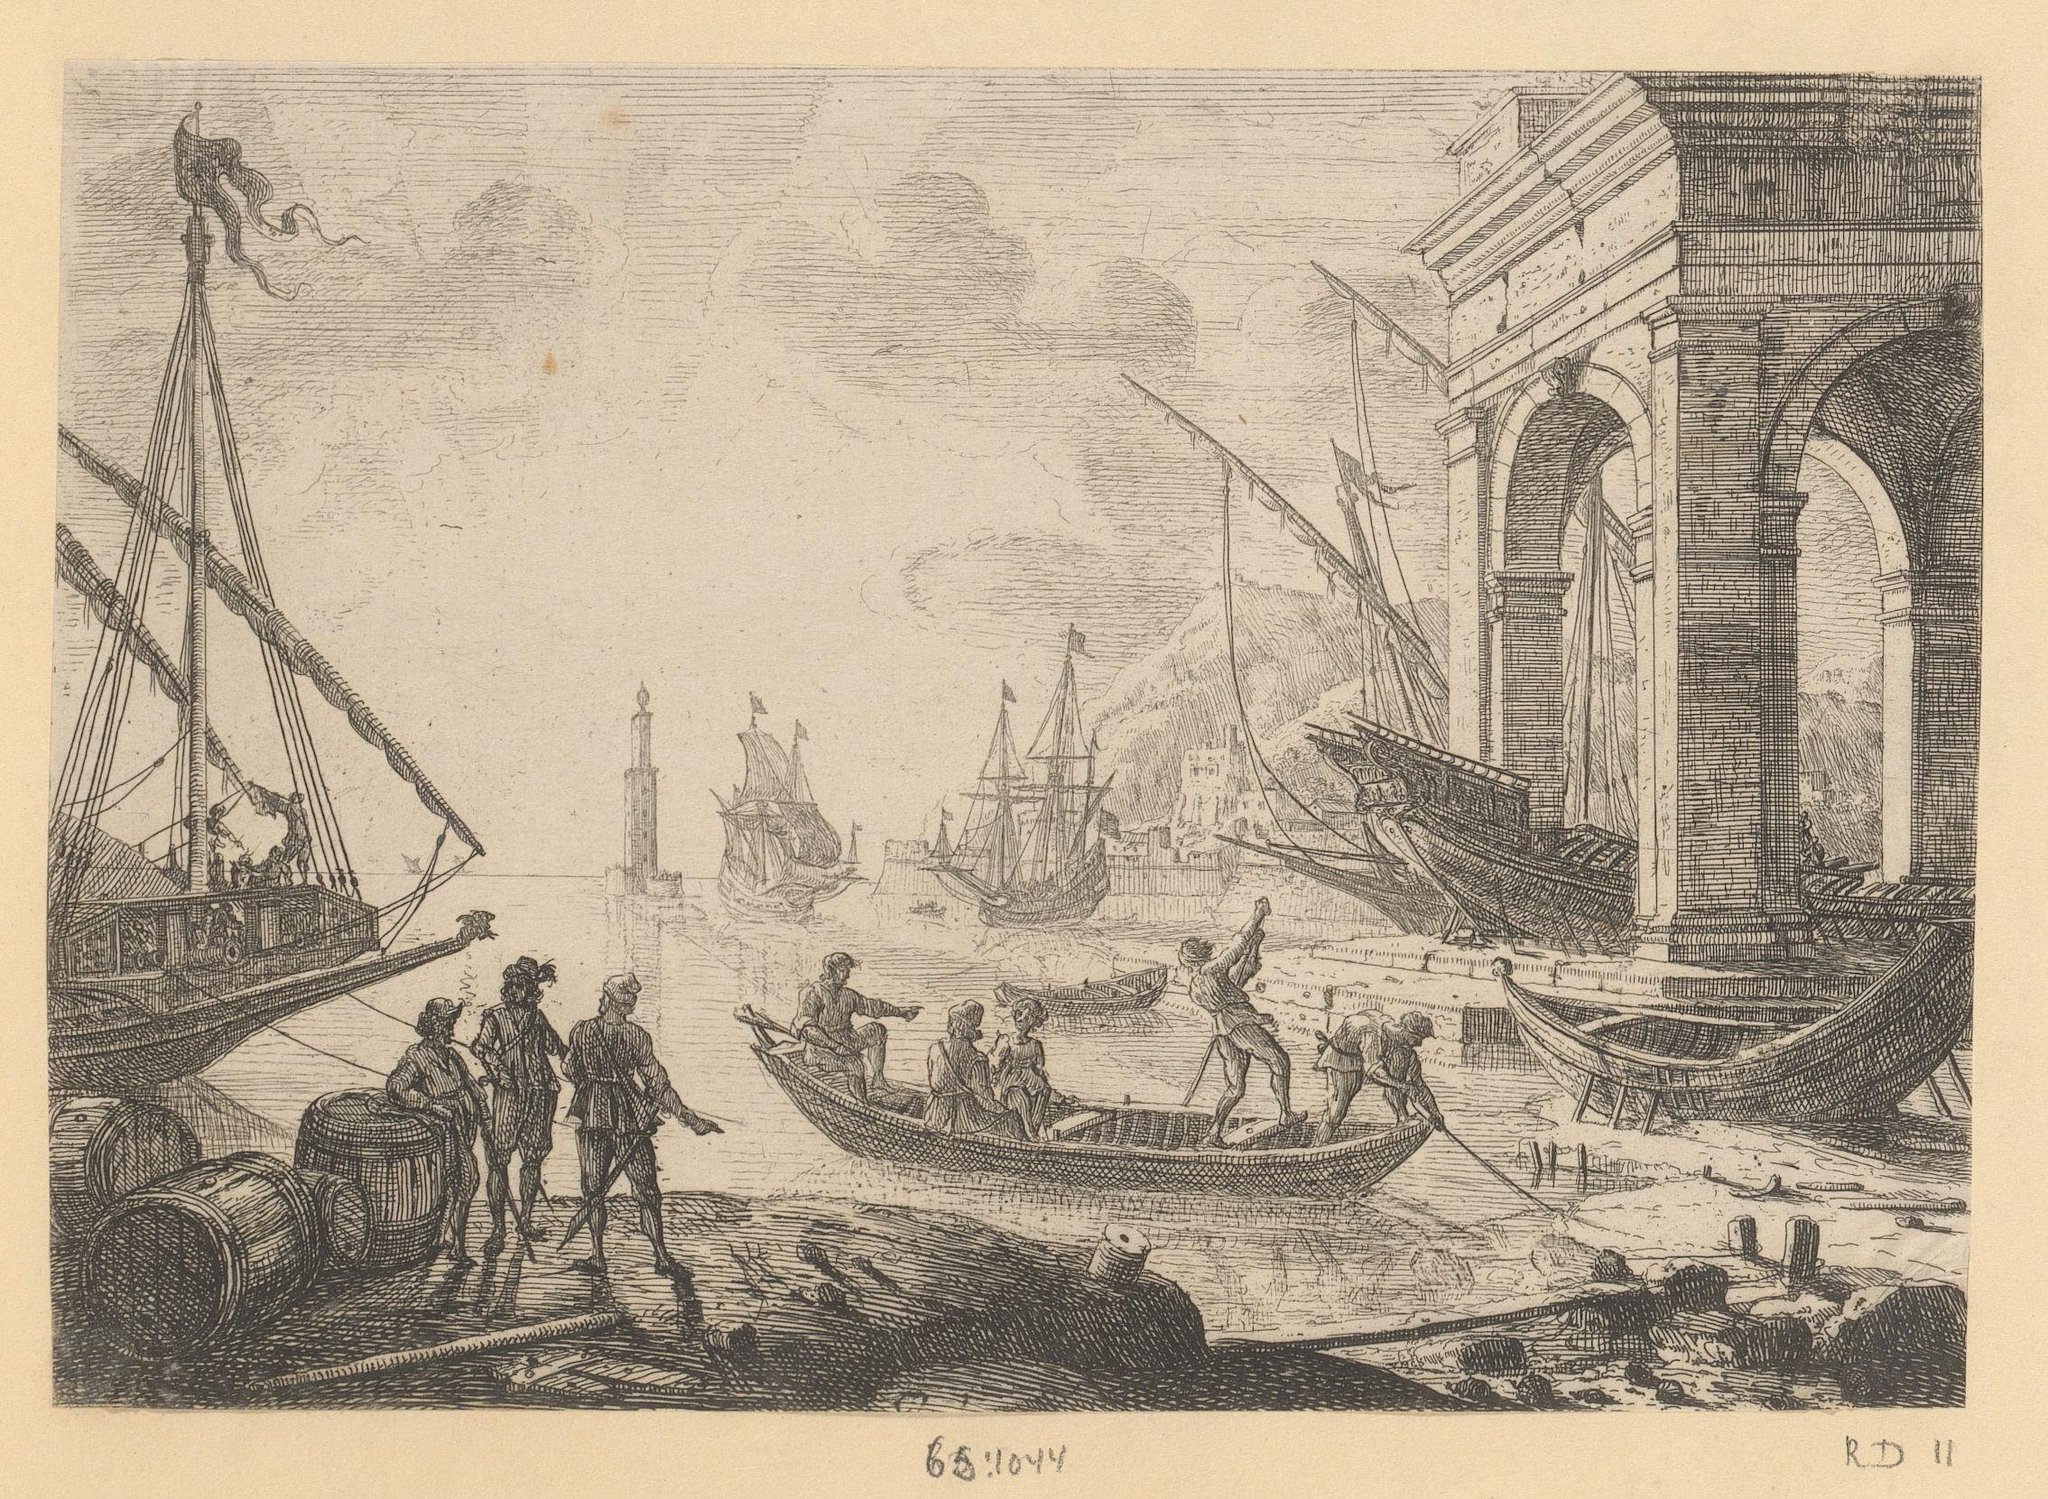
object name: album leaf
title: Le Port de mer au fanal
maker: claude lorrain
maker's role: draughtsman, print maker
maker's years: 1604-1682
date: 1634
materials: paper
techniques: etching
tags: harbour, lighthouse, lightship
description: Prent maakt mogelijk deel uit van een serie van 200 prenten. Deze serie is onder de titel 'A Collection of two hundred original etchings' voor het eerst uitgegeven door J.M. Greery in 1816.